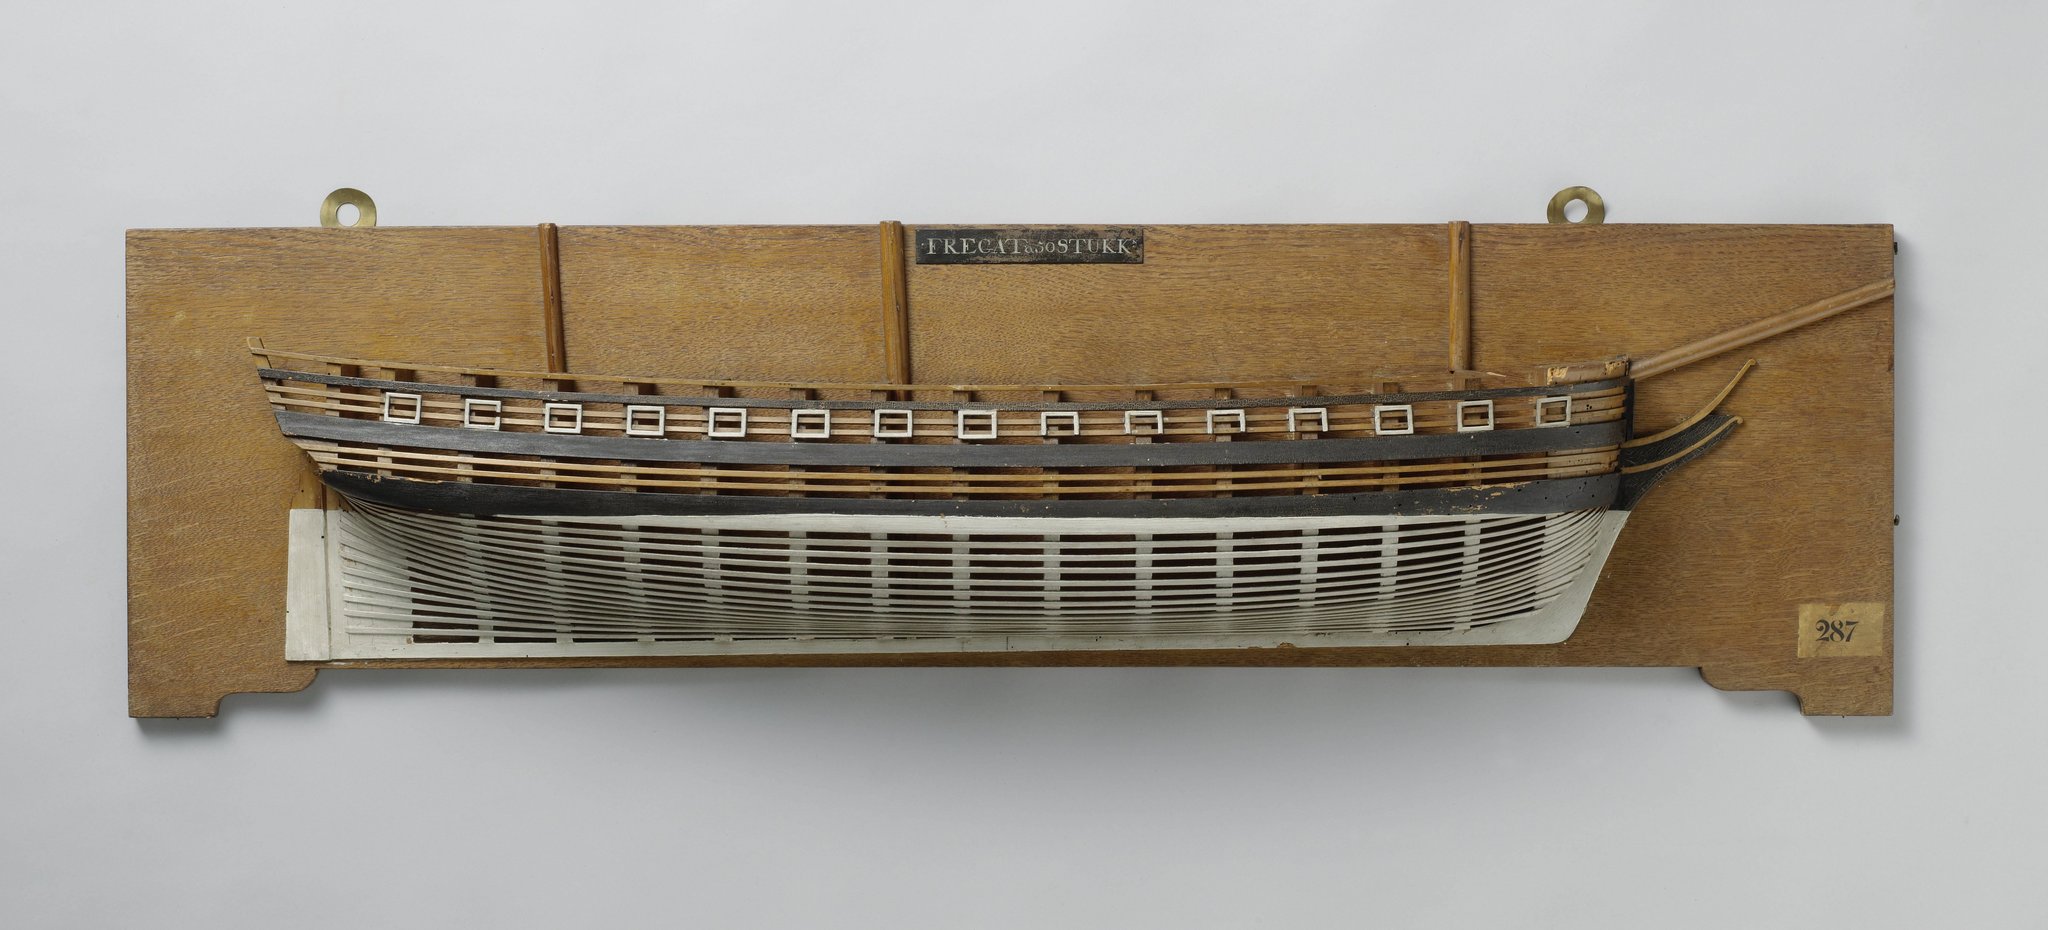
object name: builder's model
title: Half Model of a 50-Gun Frigate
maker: Anonymous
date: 1780-1825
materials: wood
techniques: polychromy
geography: netherlands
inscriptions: inscription, top centre, on a square black metal label: ‘FREGAT à 50 STUKKn’, label, bottom right: ‘287’ former inventory label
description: Gepolychromeerd mallenmodel (stuurboord) van een driemaster. Vijftien geschutpoorten aangegeven op één dek. Gewrongen spiegel, hol wulf, geen details van hek of zijgalerij; recht roer met vierkante roerkoning. Zeeg aan beide uiteinden iets oplopend, twee berghouten en één reehout. Gepiekt rondspant.